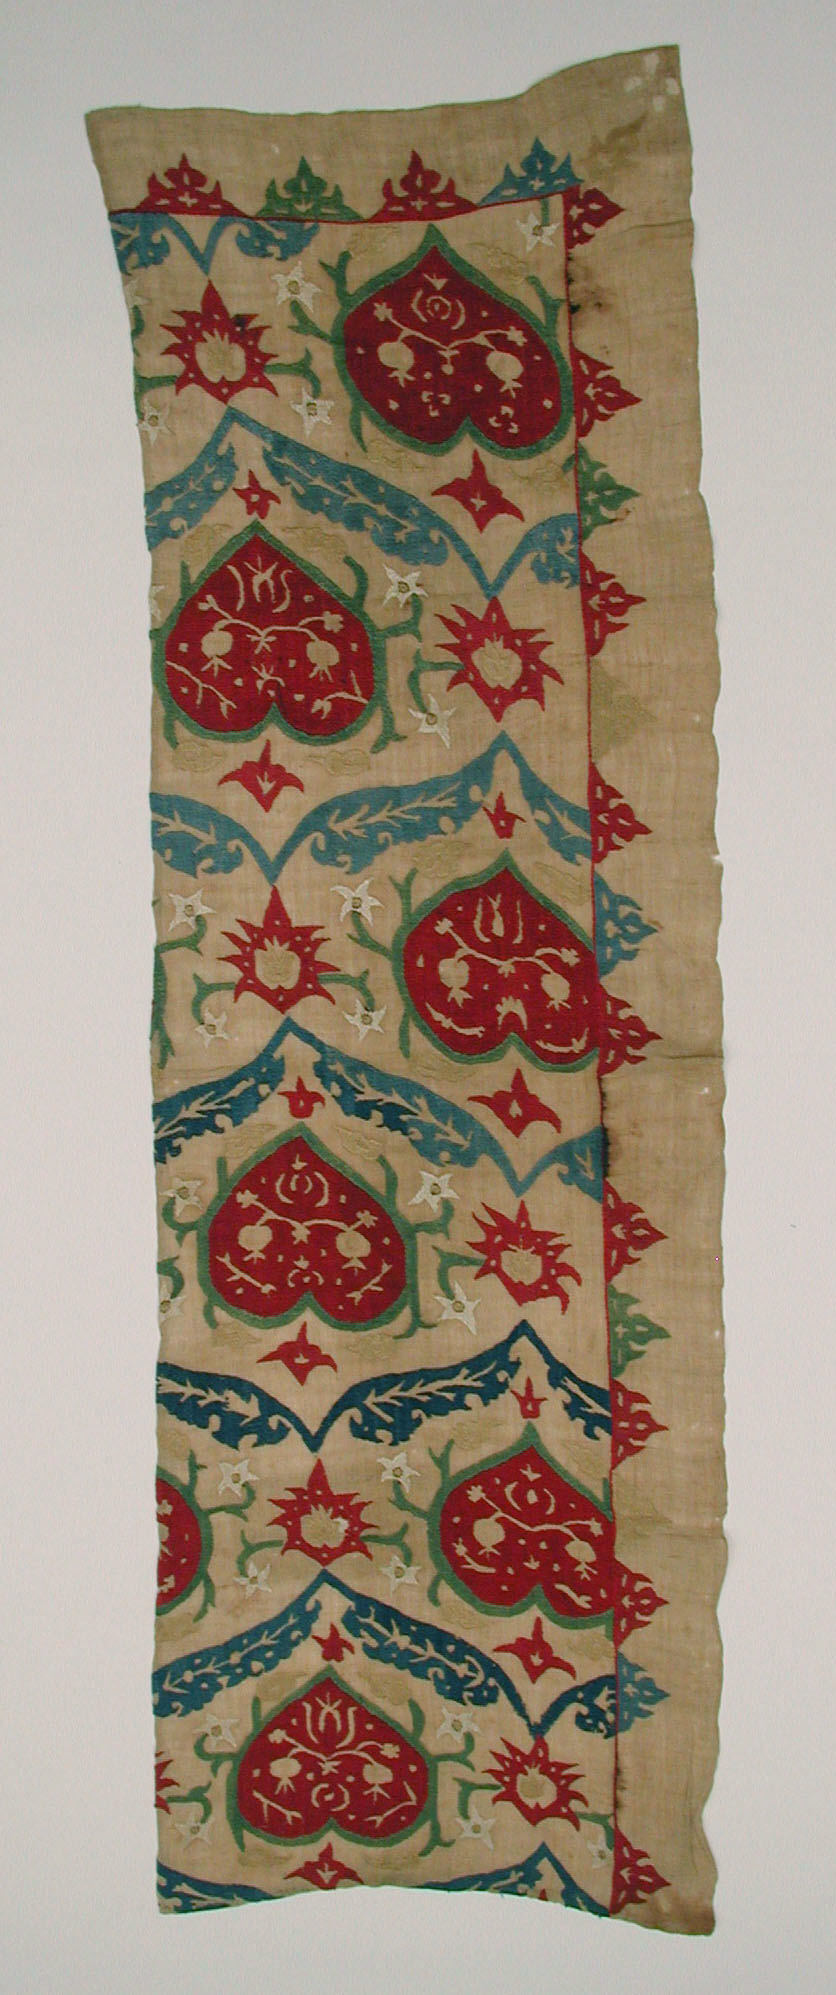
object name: textile fragment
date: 1601-1800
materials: linen, silk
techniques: embroidery, weave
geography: turkey